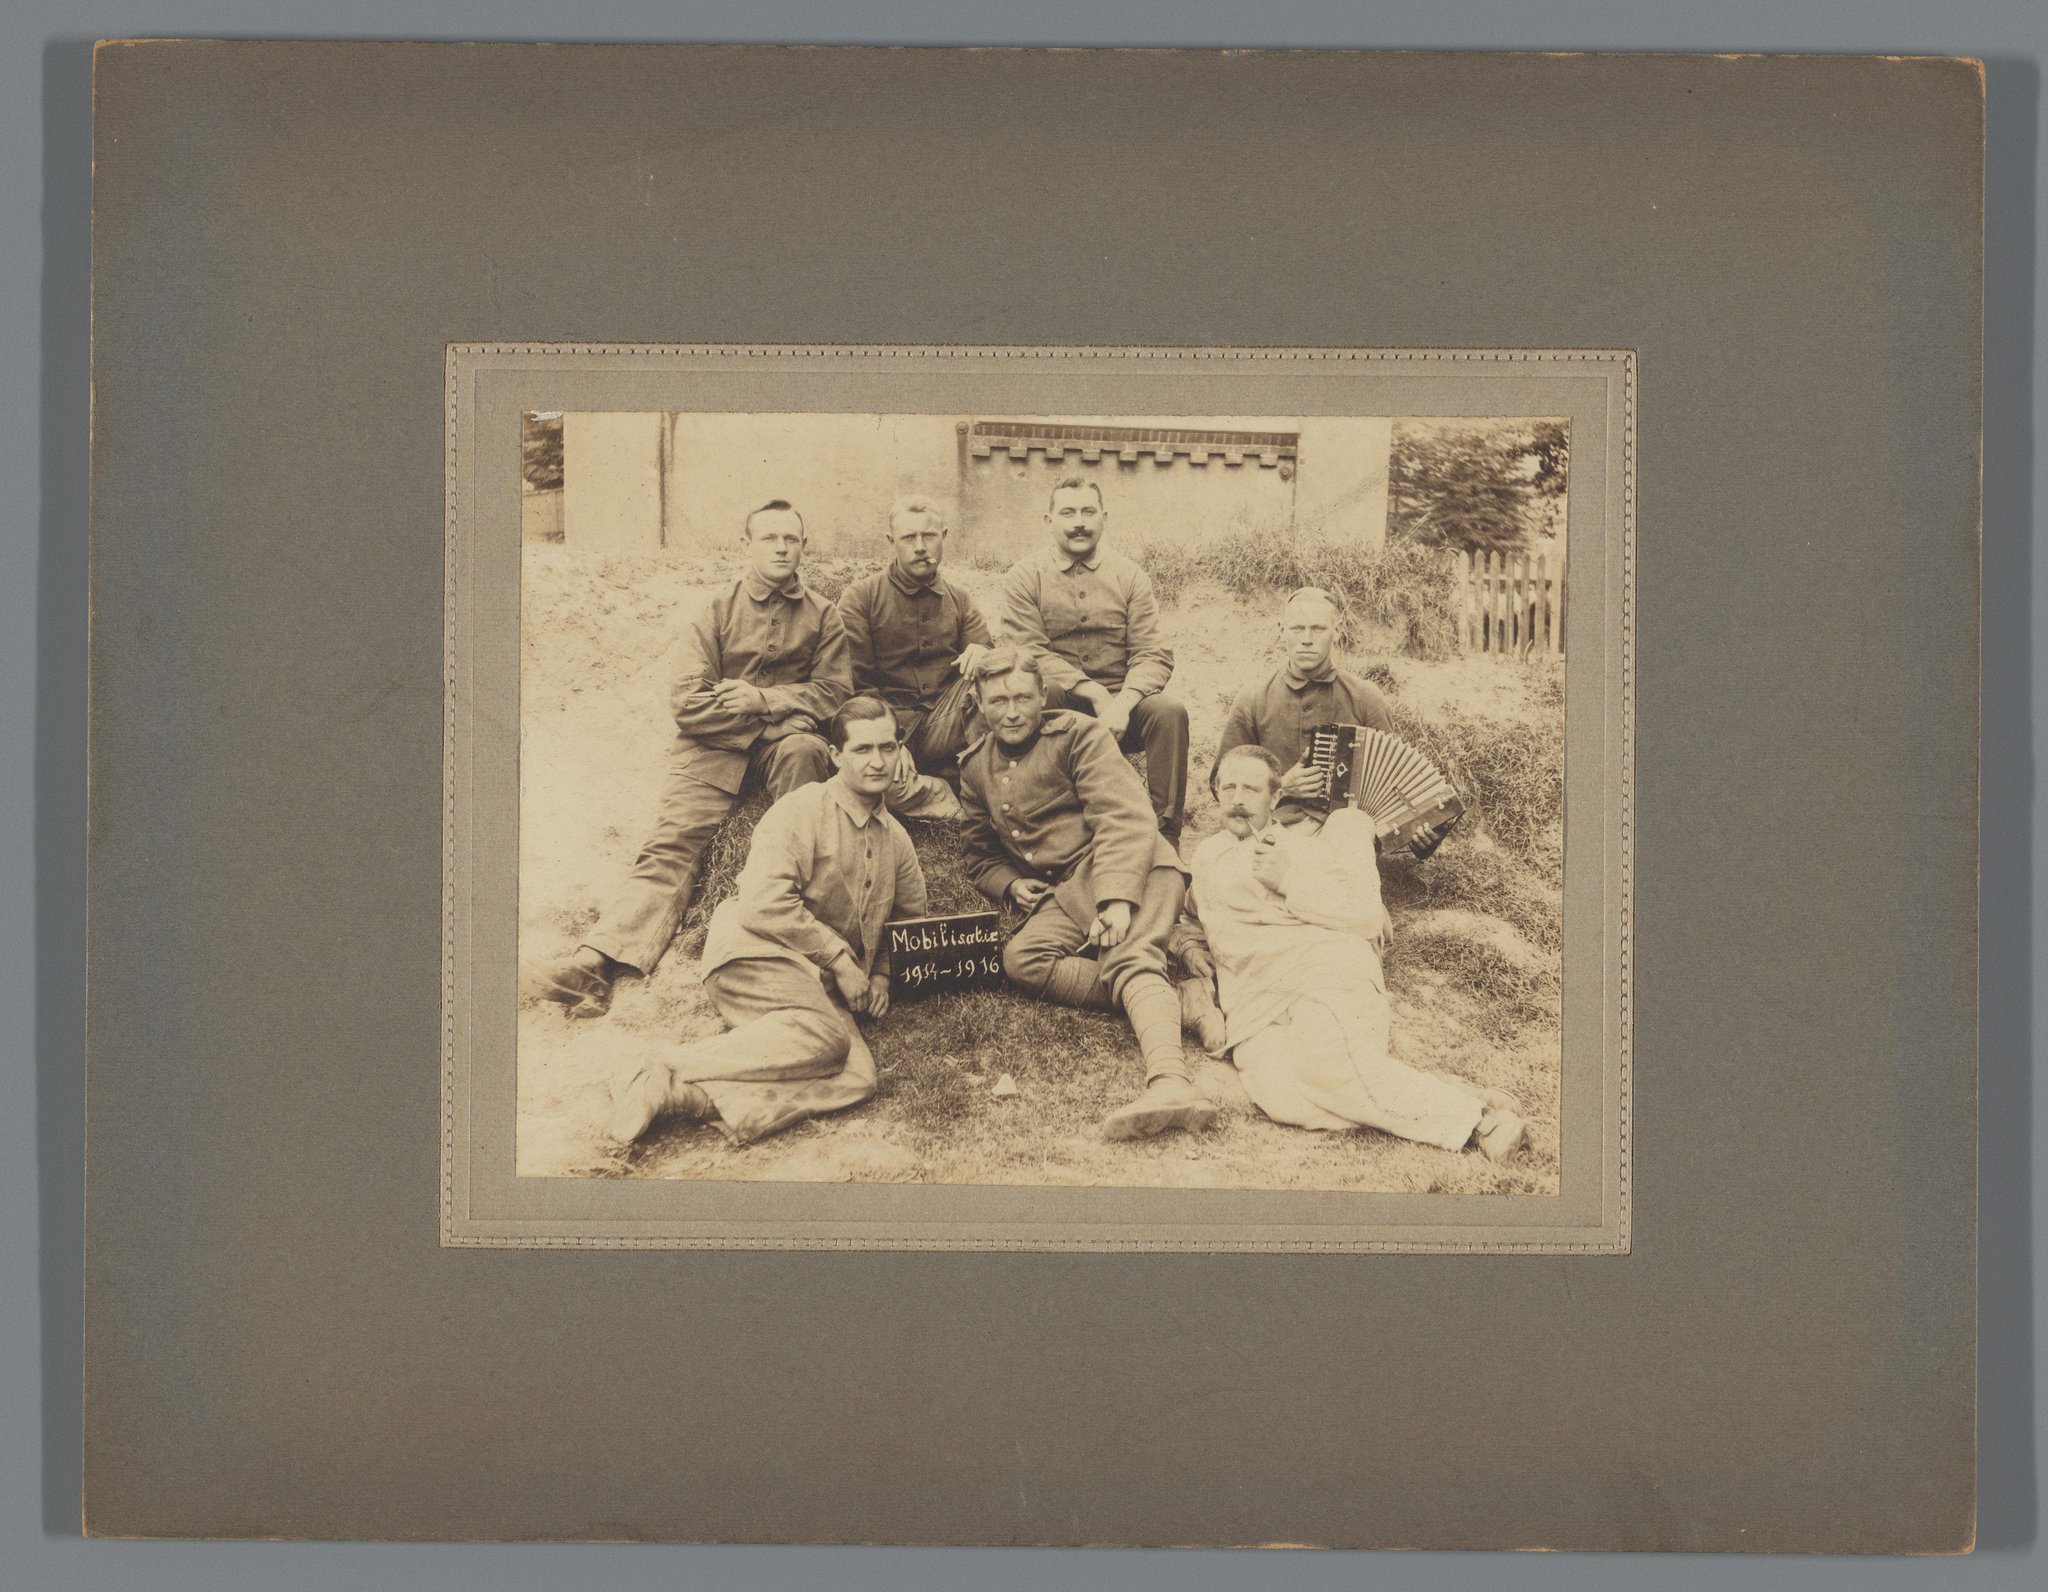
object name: photograph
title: Groepsportret van zeven onbekende Nederlandse militairen, gemobiliseerd tijdens de Eerste Wereldoorlog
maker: Anonymous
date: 1916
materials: paper, cardboard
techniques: daylight paper print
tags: the soldier; the soldier's life, anonymous historical persons portrayed in a group, in a group-portrait